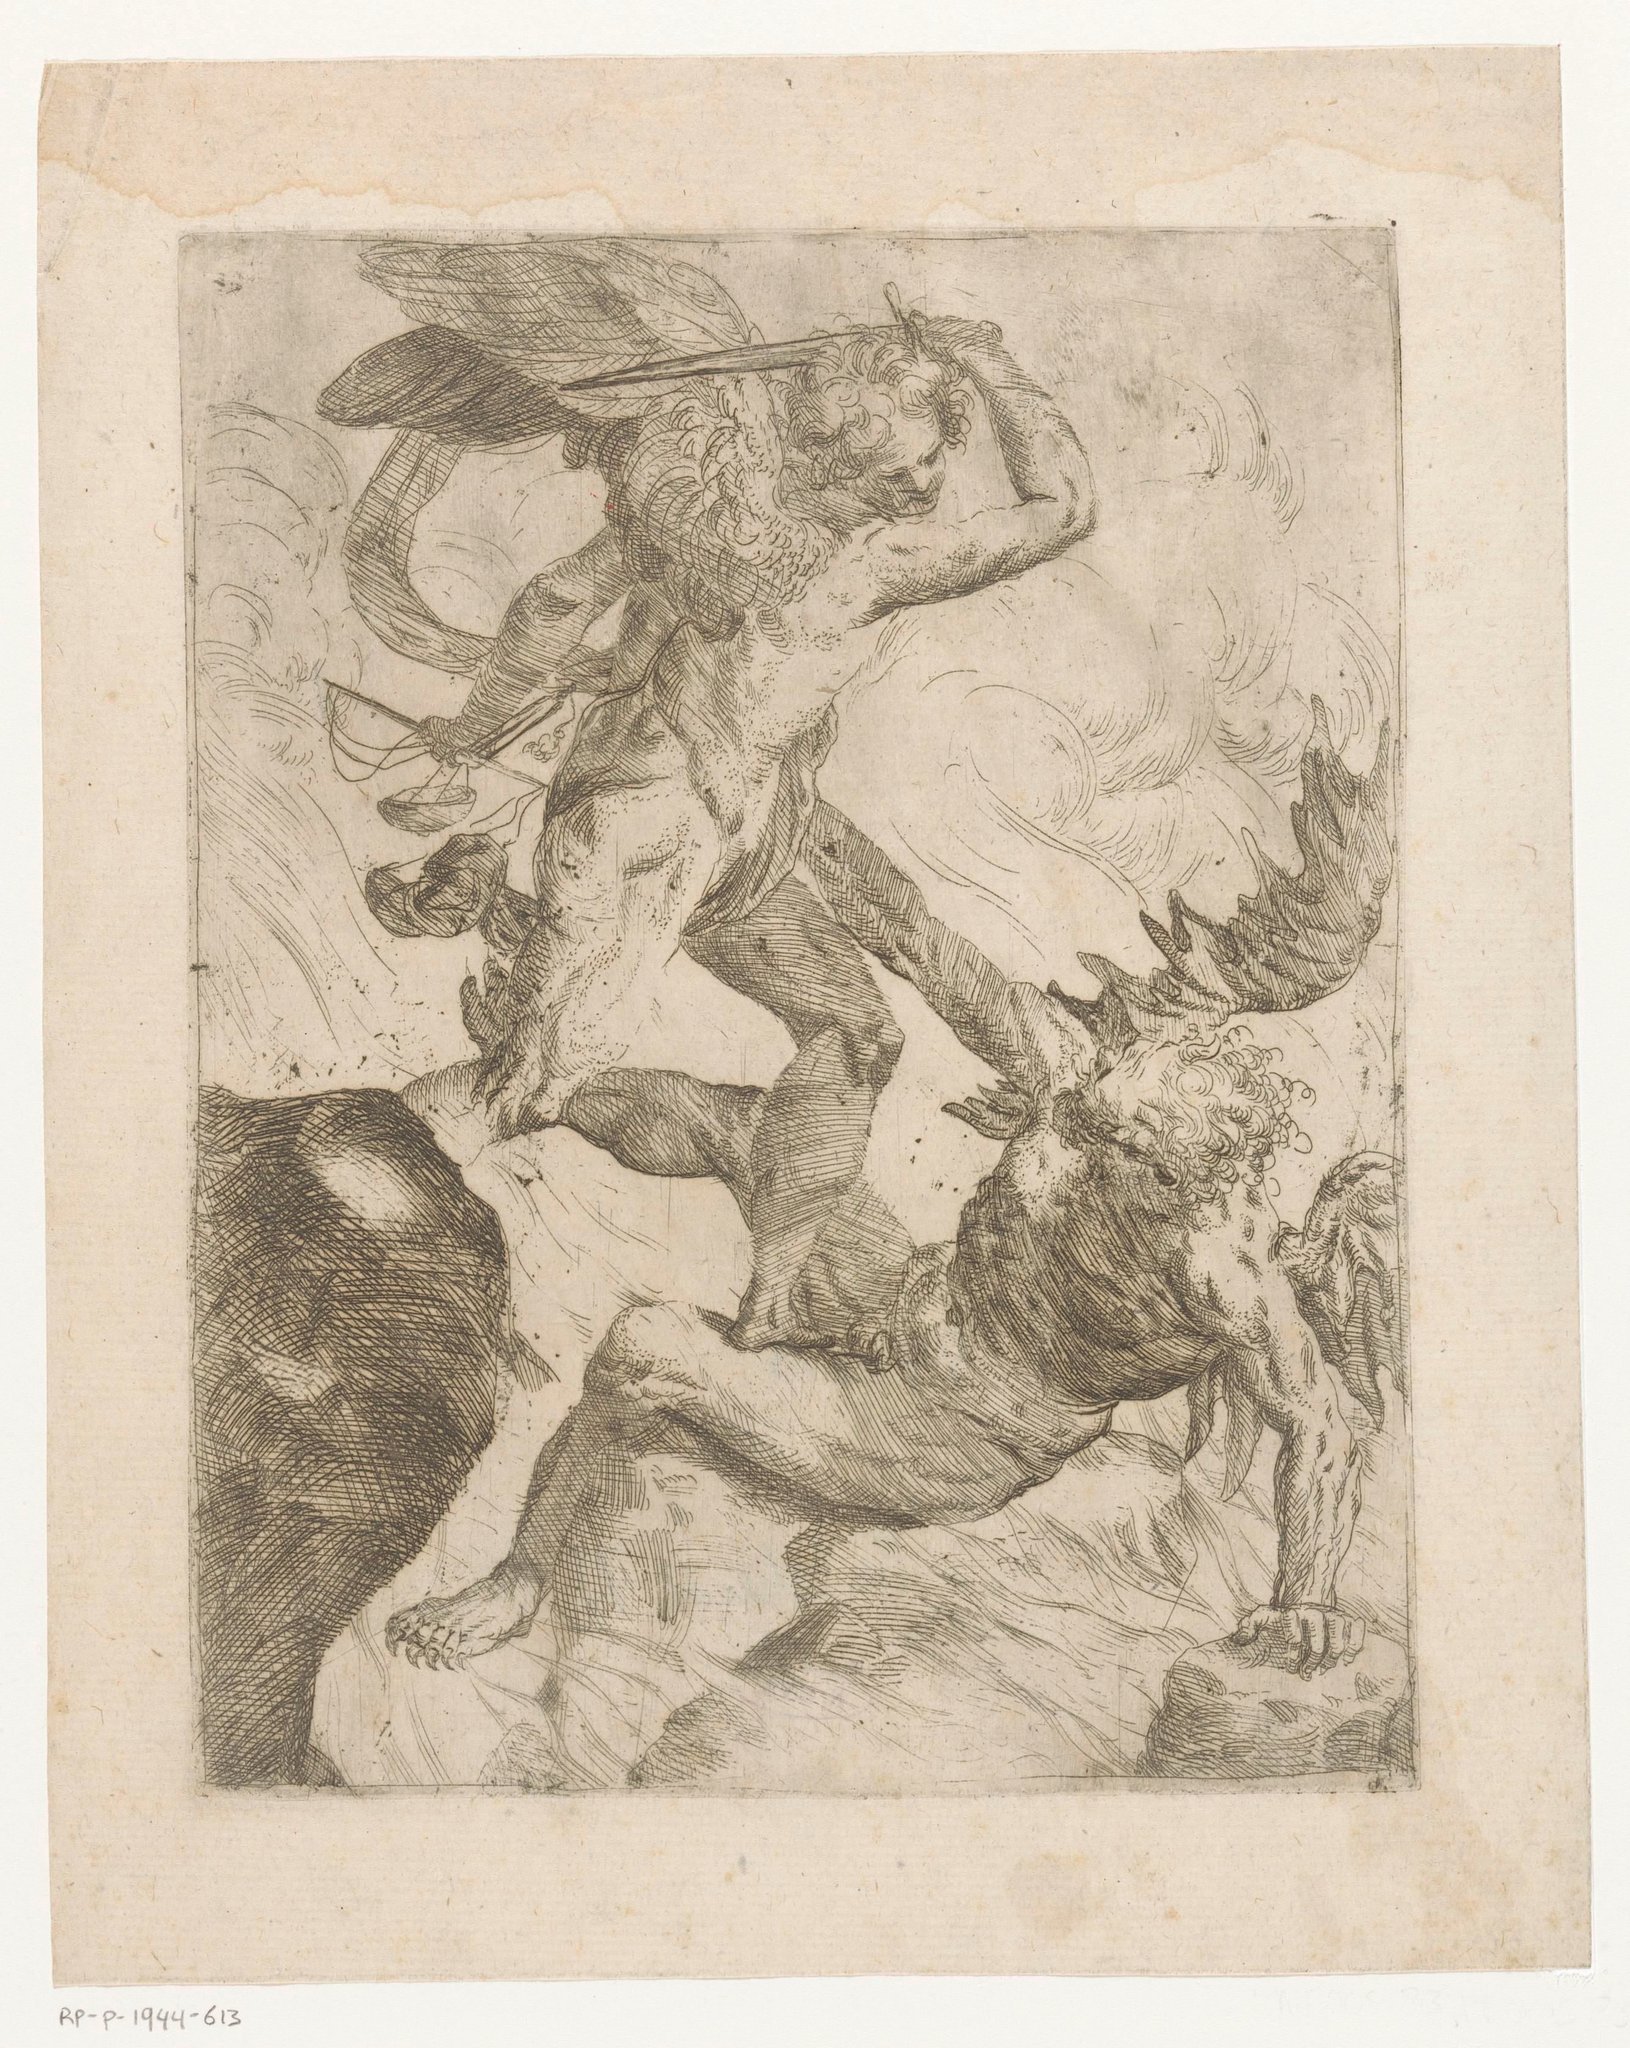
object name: print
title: Aartsengel Michaël in gevecht met de duivel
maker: giovanni pietro possenti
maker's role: print maker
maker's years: 1618-1659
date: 1628-1659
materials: paper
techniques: etching, intaglio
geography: italy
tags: the archangel michael fighting the dragon (devil, satan)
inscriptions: collector's mark: Lugt 2228